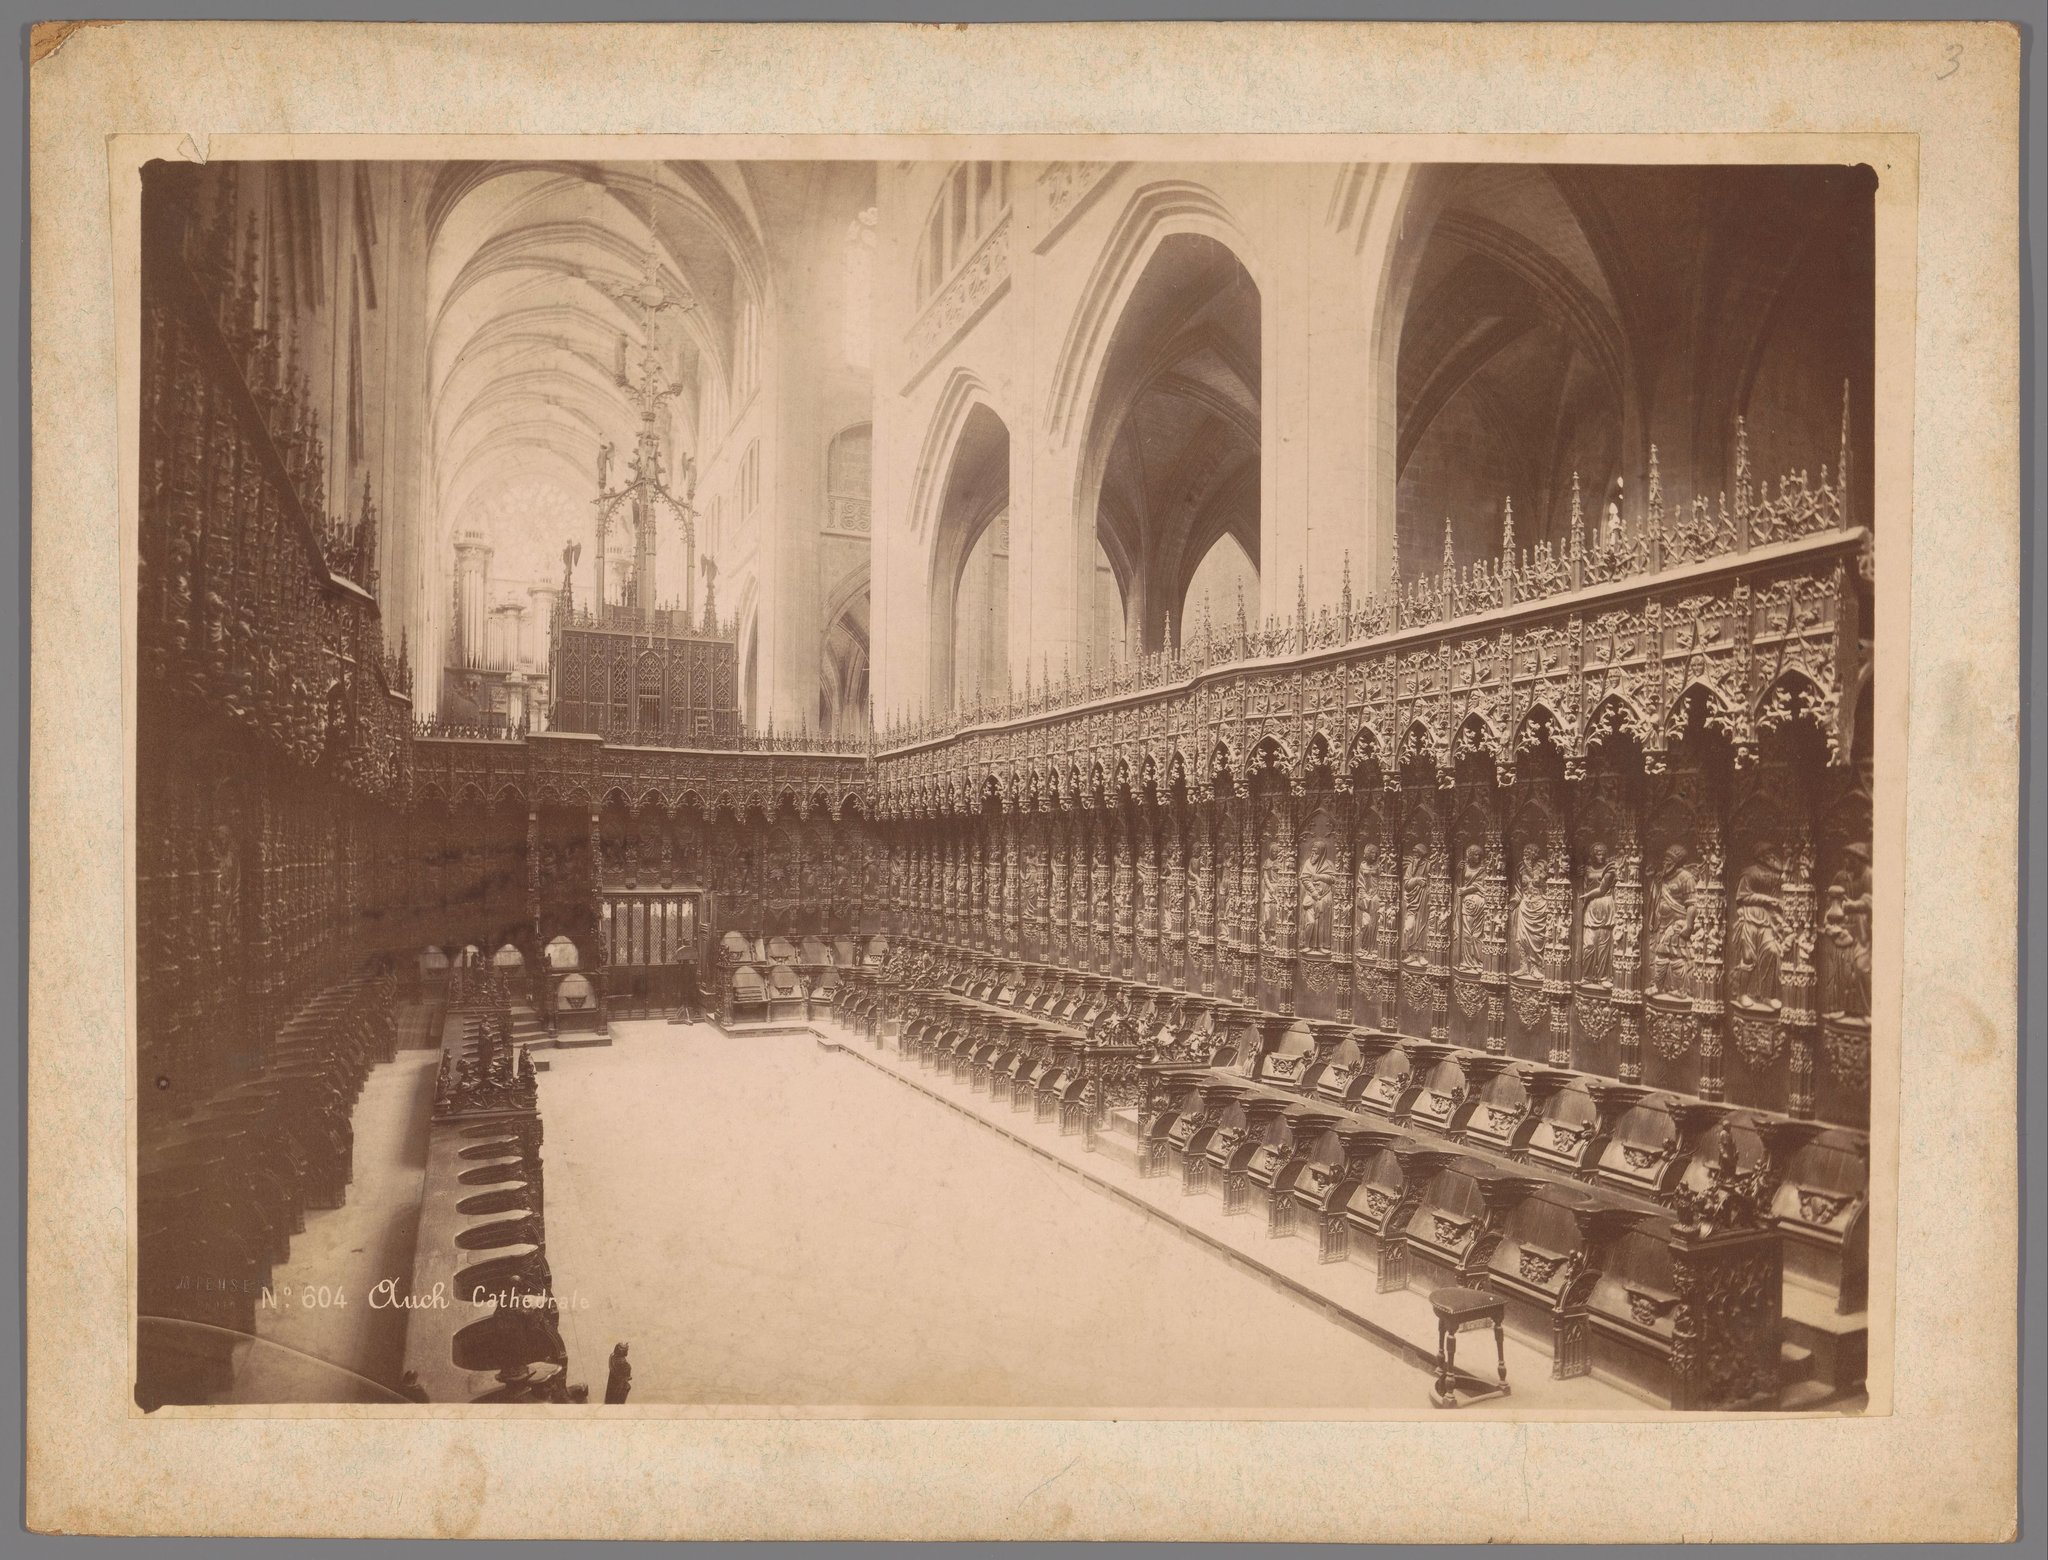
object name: photograph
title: Auch Cathédrale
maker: séraphin-médéric mieusement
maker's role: fotograaf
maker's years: 1840-1905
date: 1875-1900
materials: cardboard, photographic support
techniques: albumen print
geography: auch cathedral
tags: parts of church interior: nave, seats of the clergy, choir-stalls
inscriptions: number: ‘No. 604’, collector's mark: Lugt 3937, inscription: ‘MONUMENTS HISTORIQUES’, name: ‘MIEUSEMENT PHOTOGRAPHE’